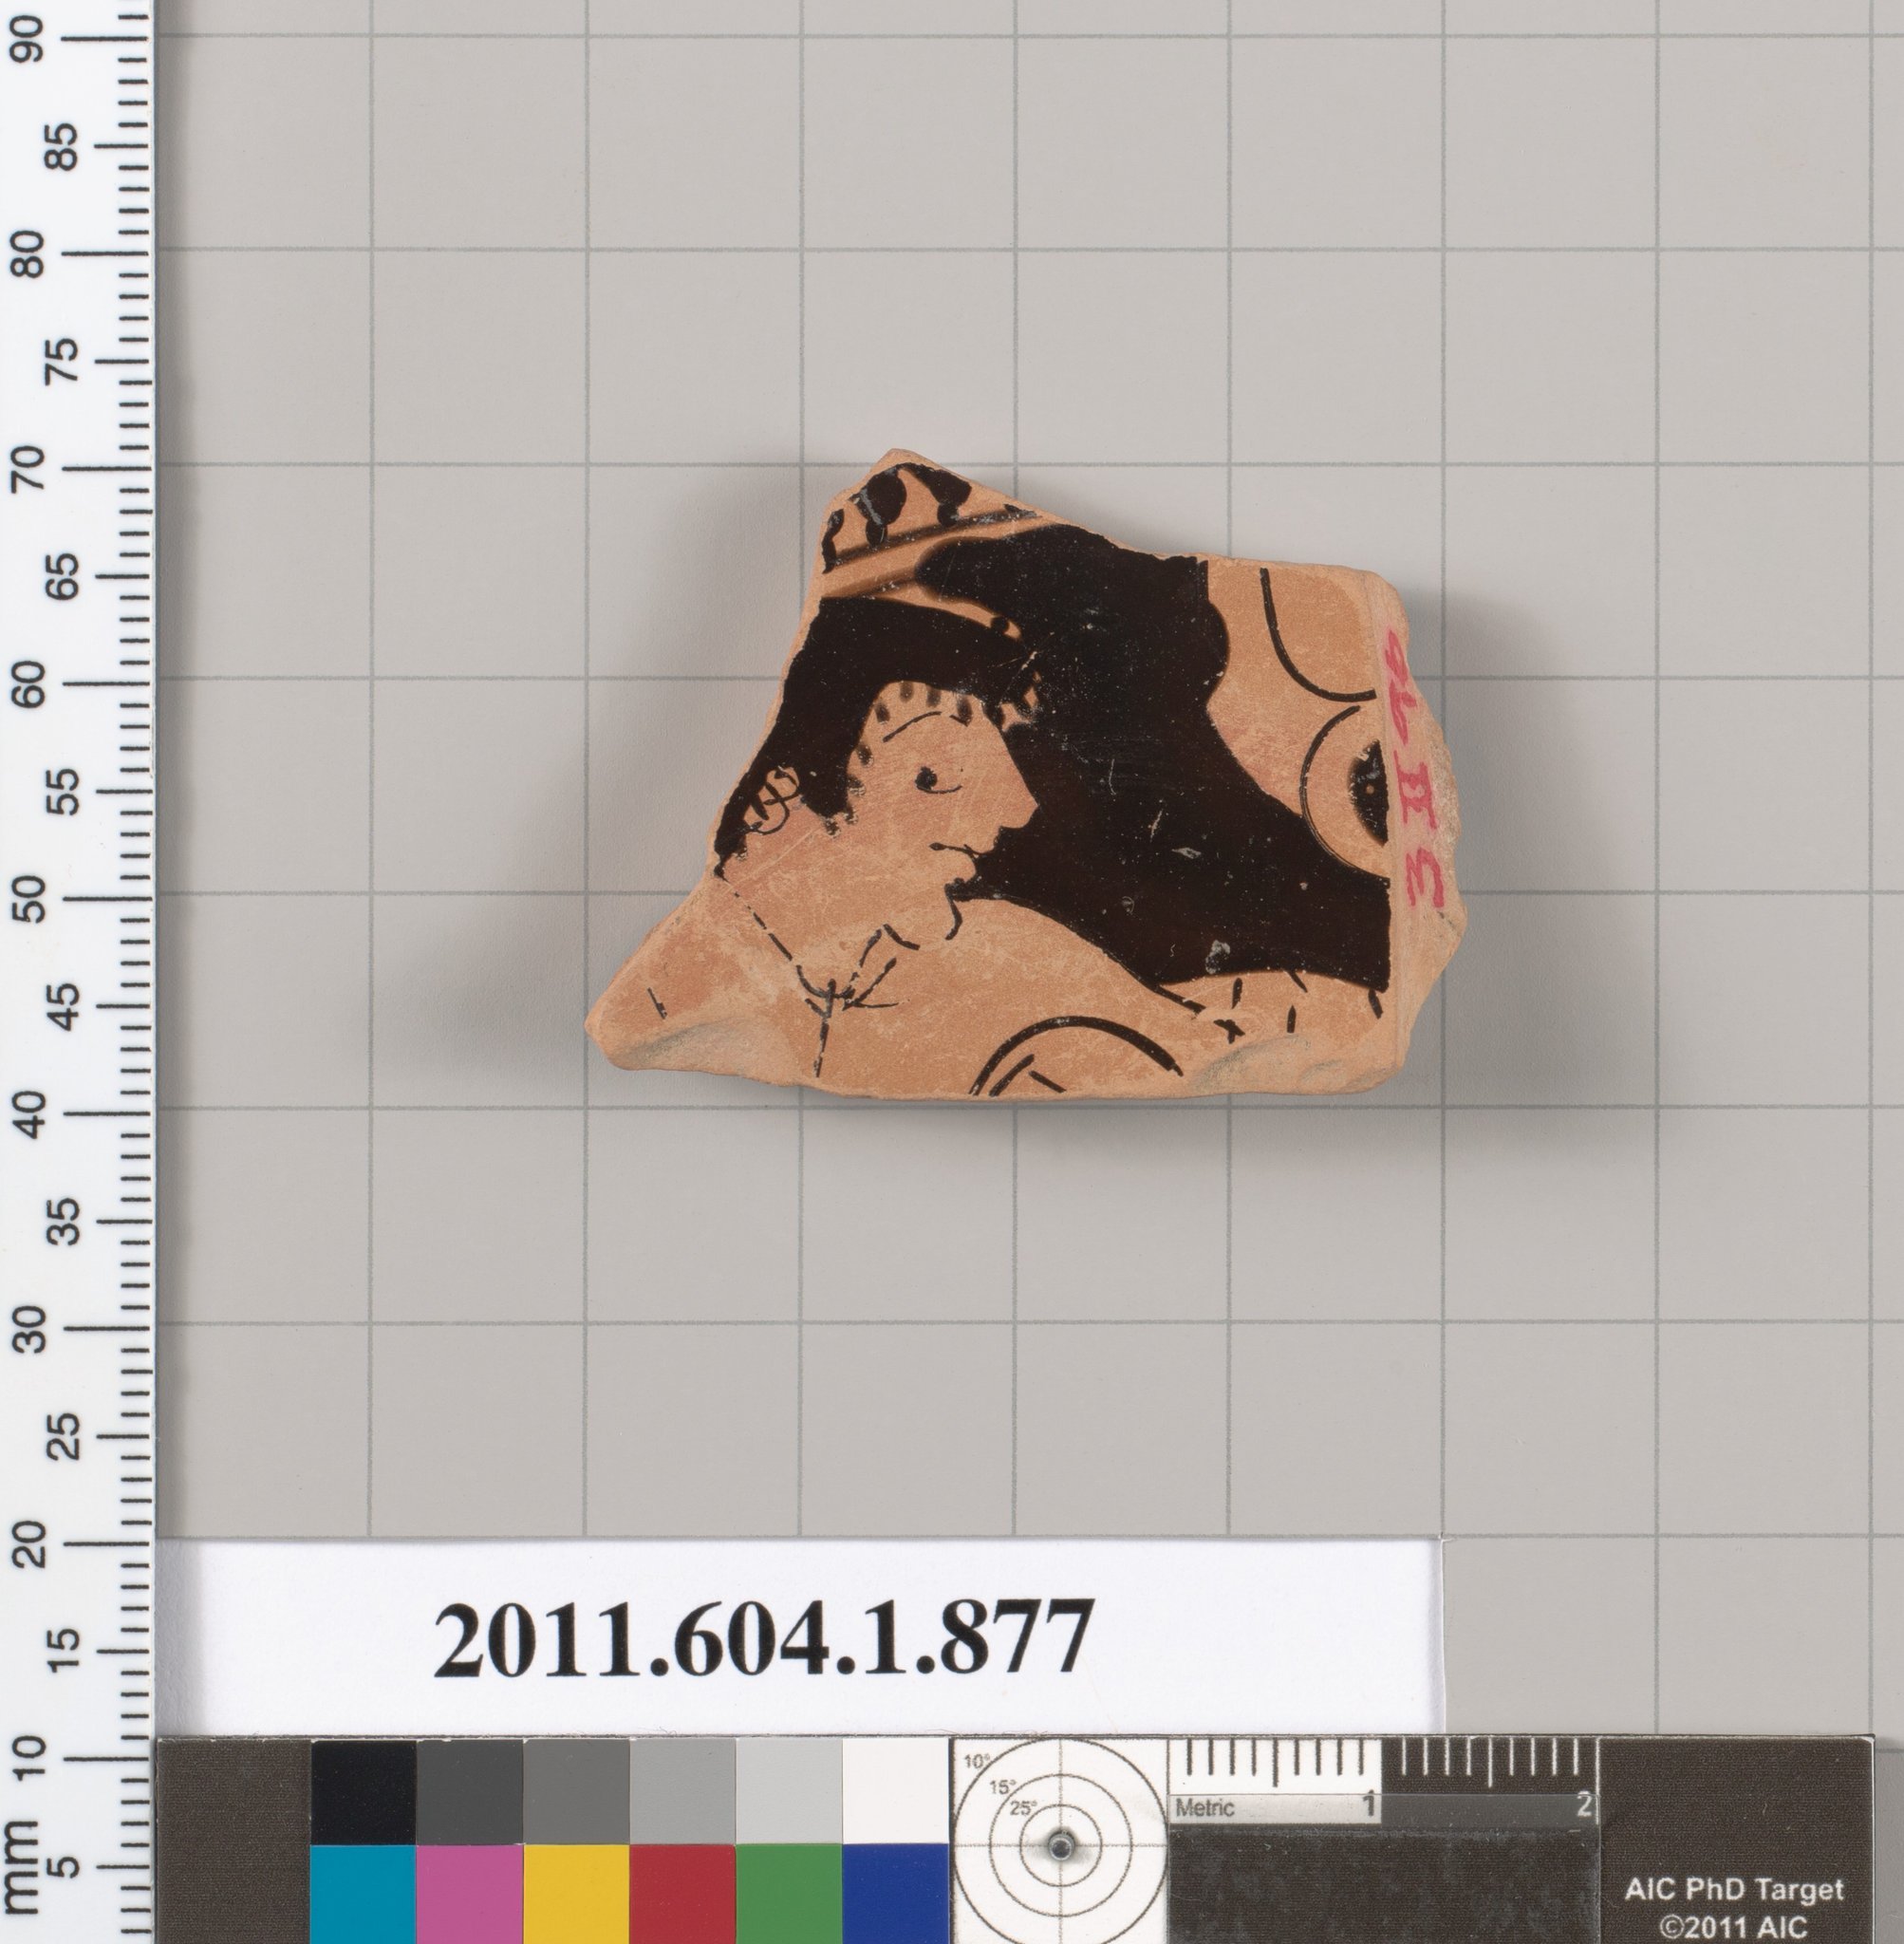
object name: kylix fragment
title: Terracotta fragment of a kylix (drinking cup)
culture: greek, attic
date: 500-476 BCE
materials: terracotta